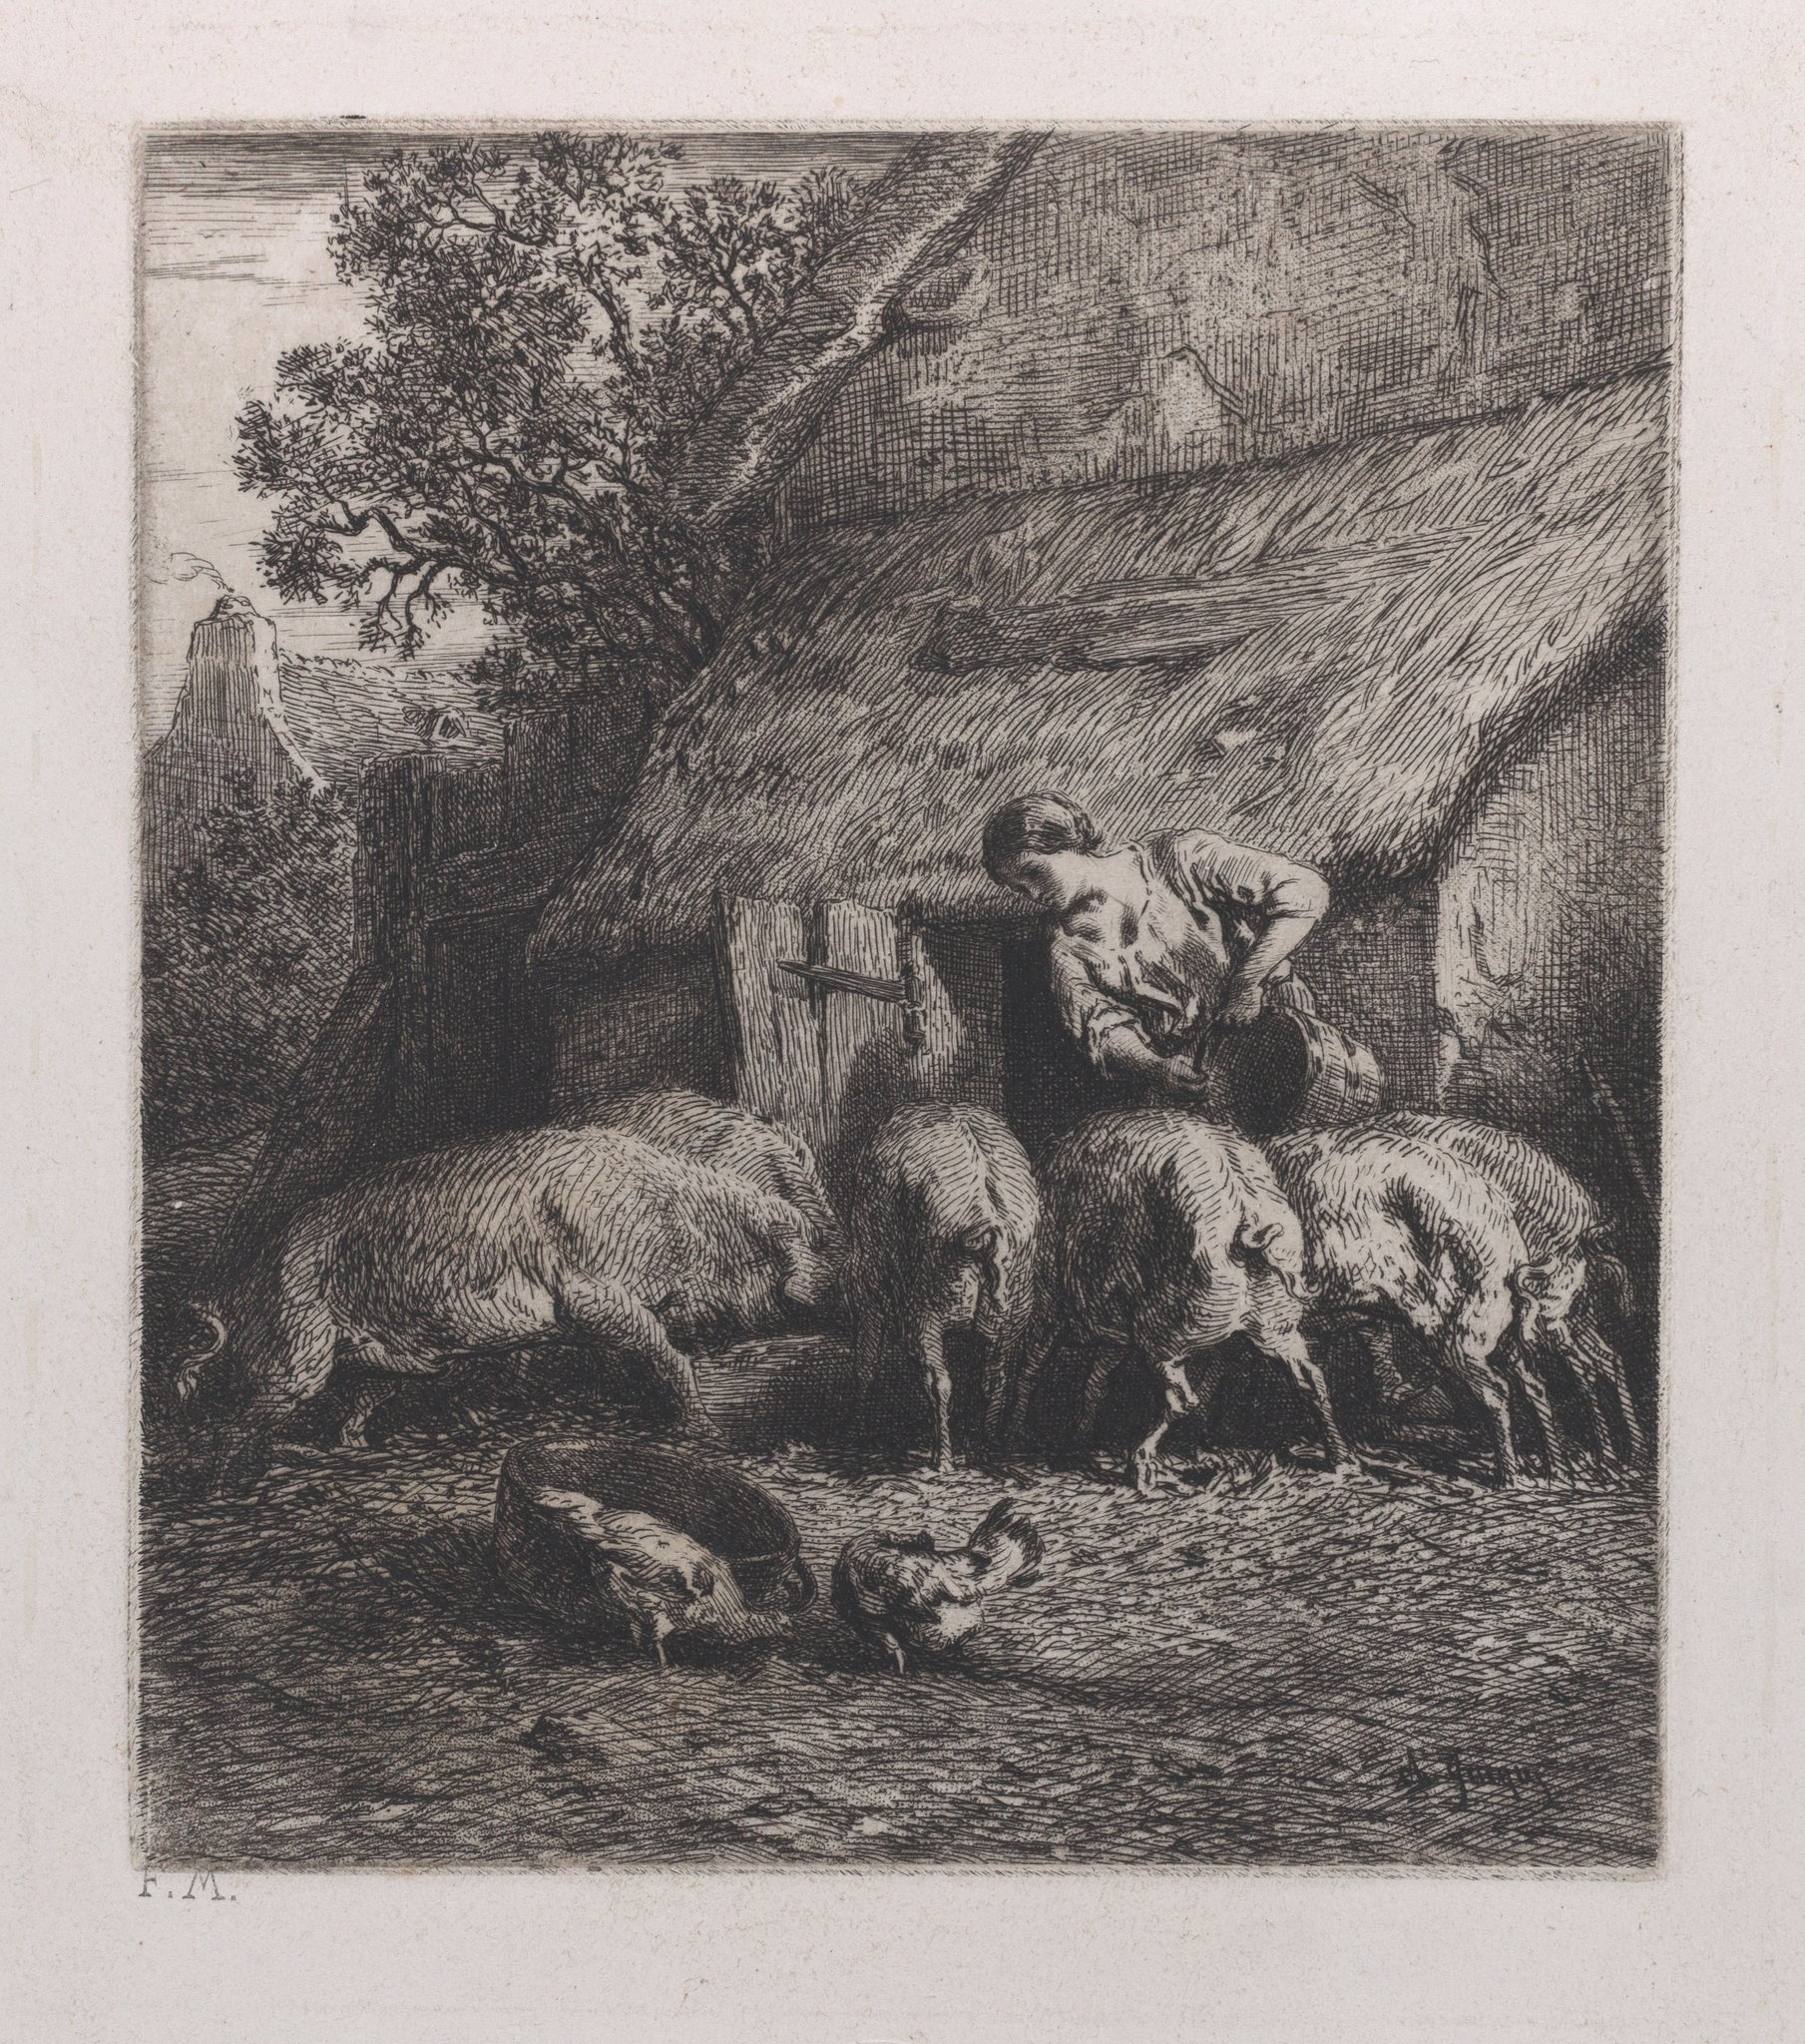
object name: print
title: Woman Feeding Pigs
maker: charles émile jacque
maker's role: artist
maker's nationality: french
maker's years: 1813-1894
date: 1850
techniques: etching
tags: women,pigs